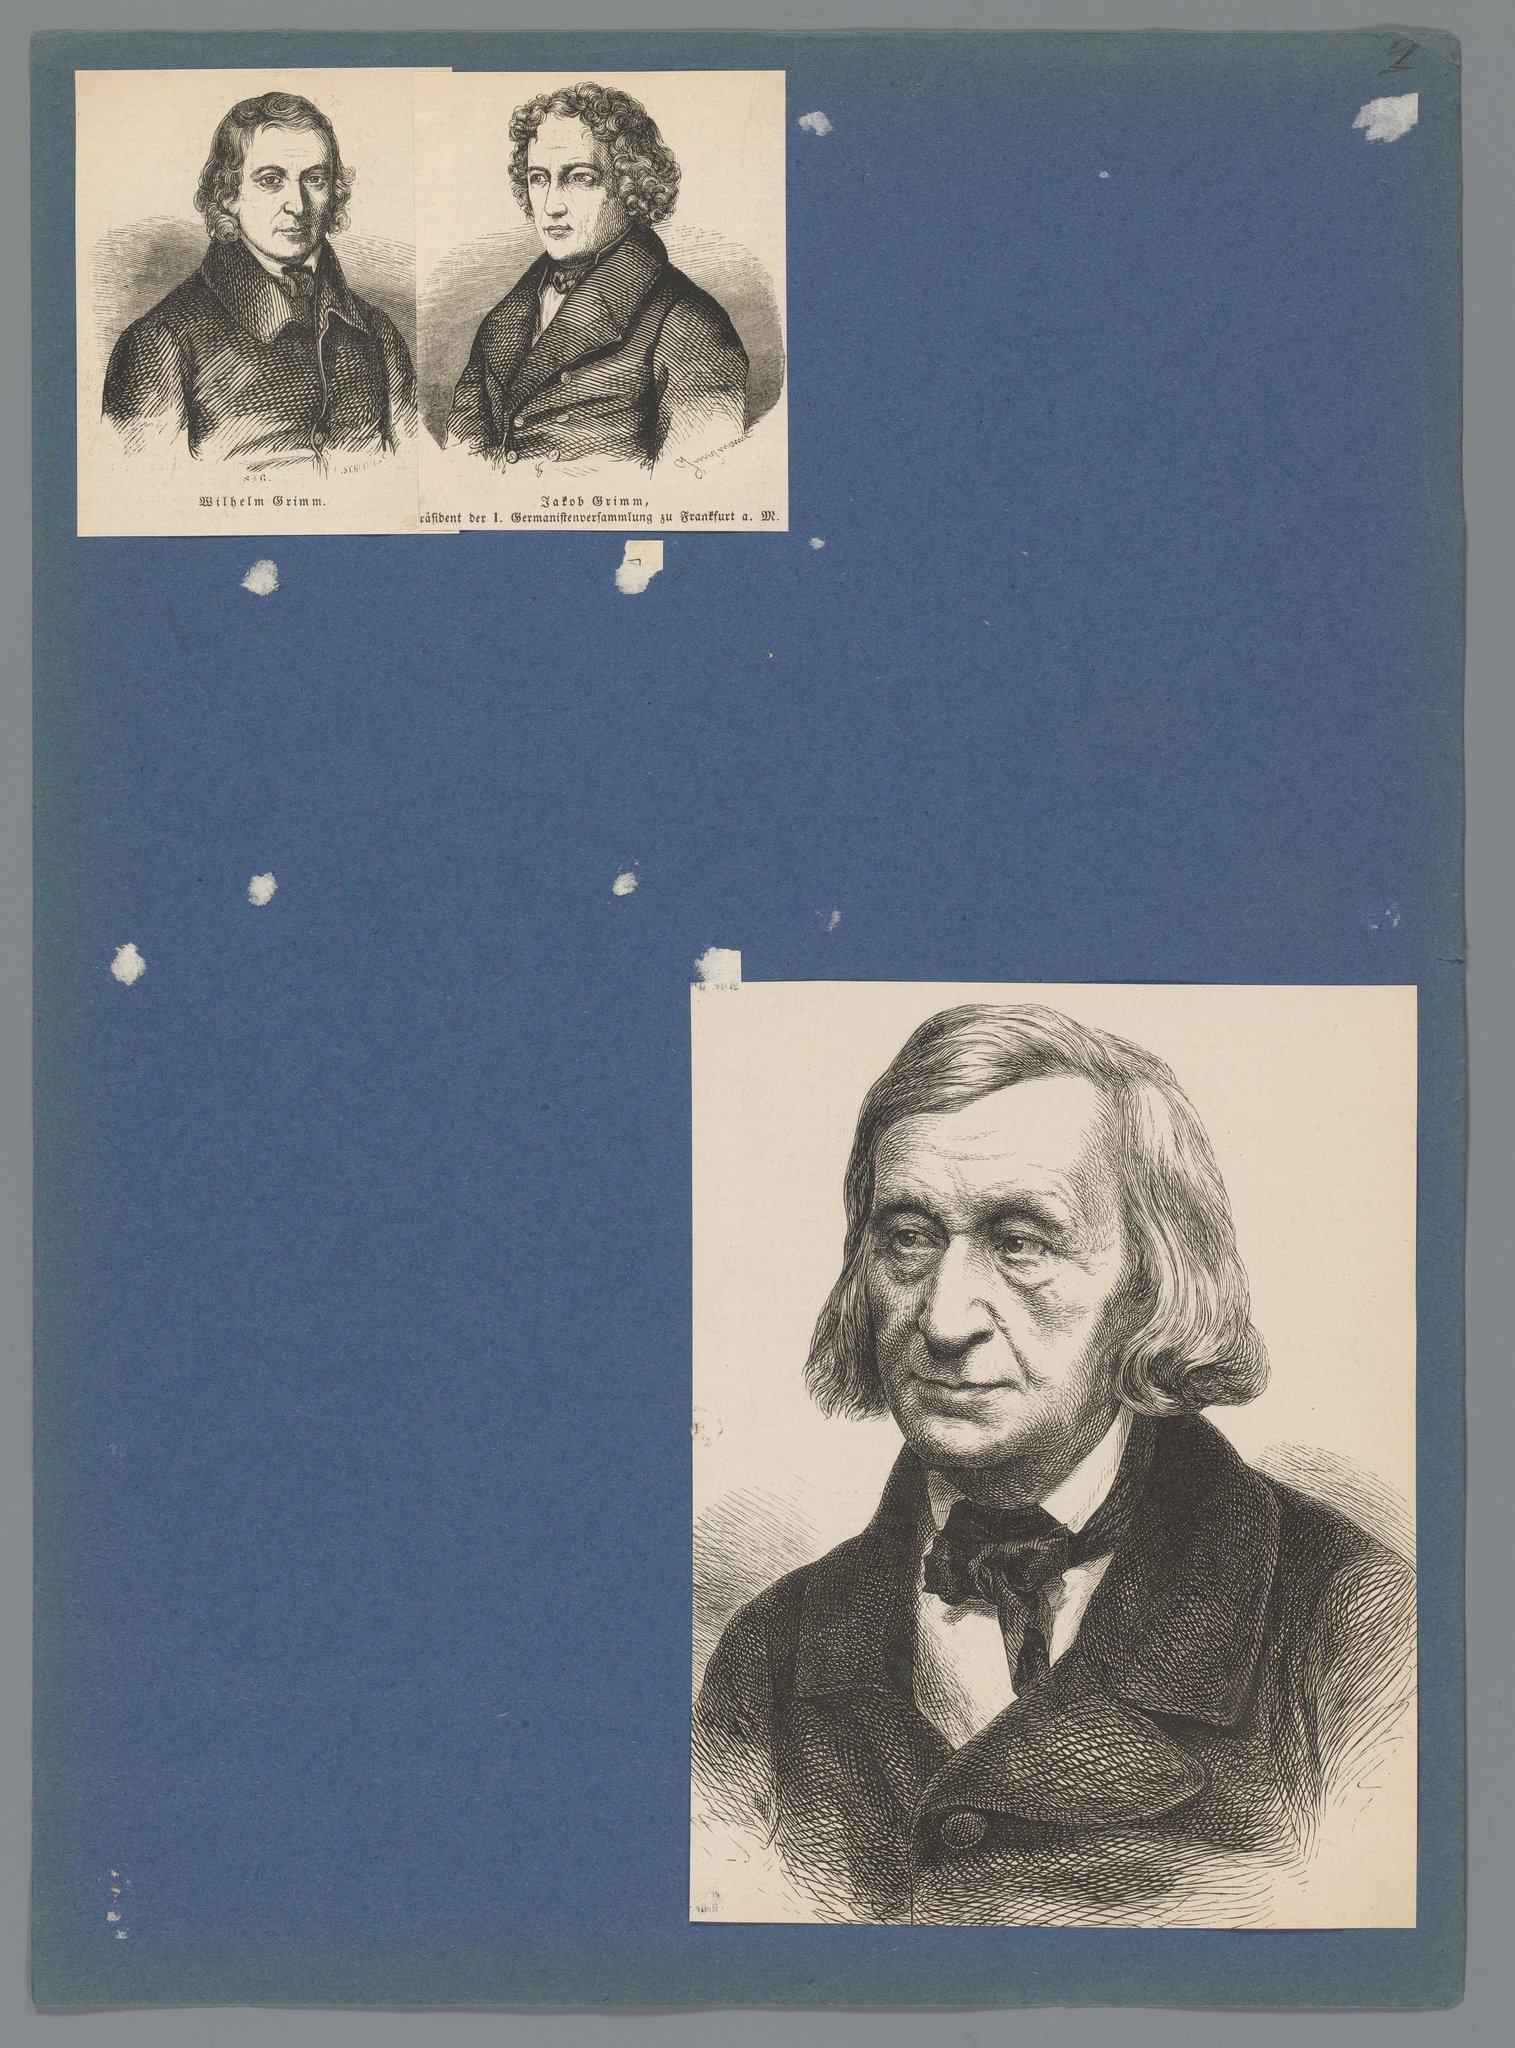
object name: sheet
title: Blad met één portret van Jacob Ludwig Karl Grimm en twee van Wilhelm Karl Grimm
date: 1850-1900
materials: paper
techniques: letterpress printing, snipping, engraving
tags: berlin, jacob ludwig karl grimm, historical persons, portrait of a writer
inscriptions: signature: ‘E.schlitte.SC.’, number: ‘2’, signature: ‘S & G’